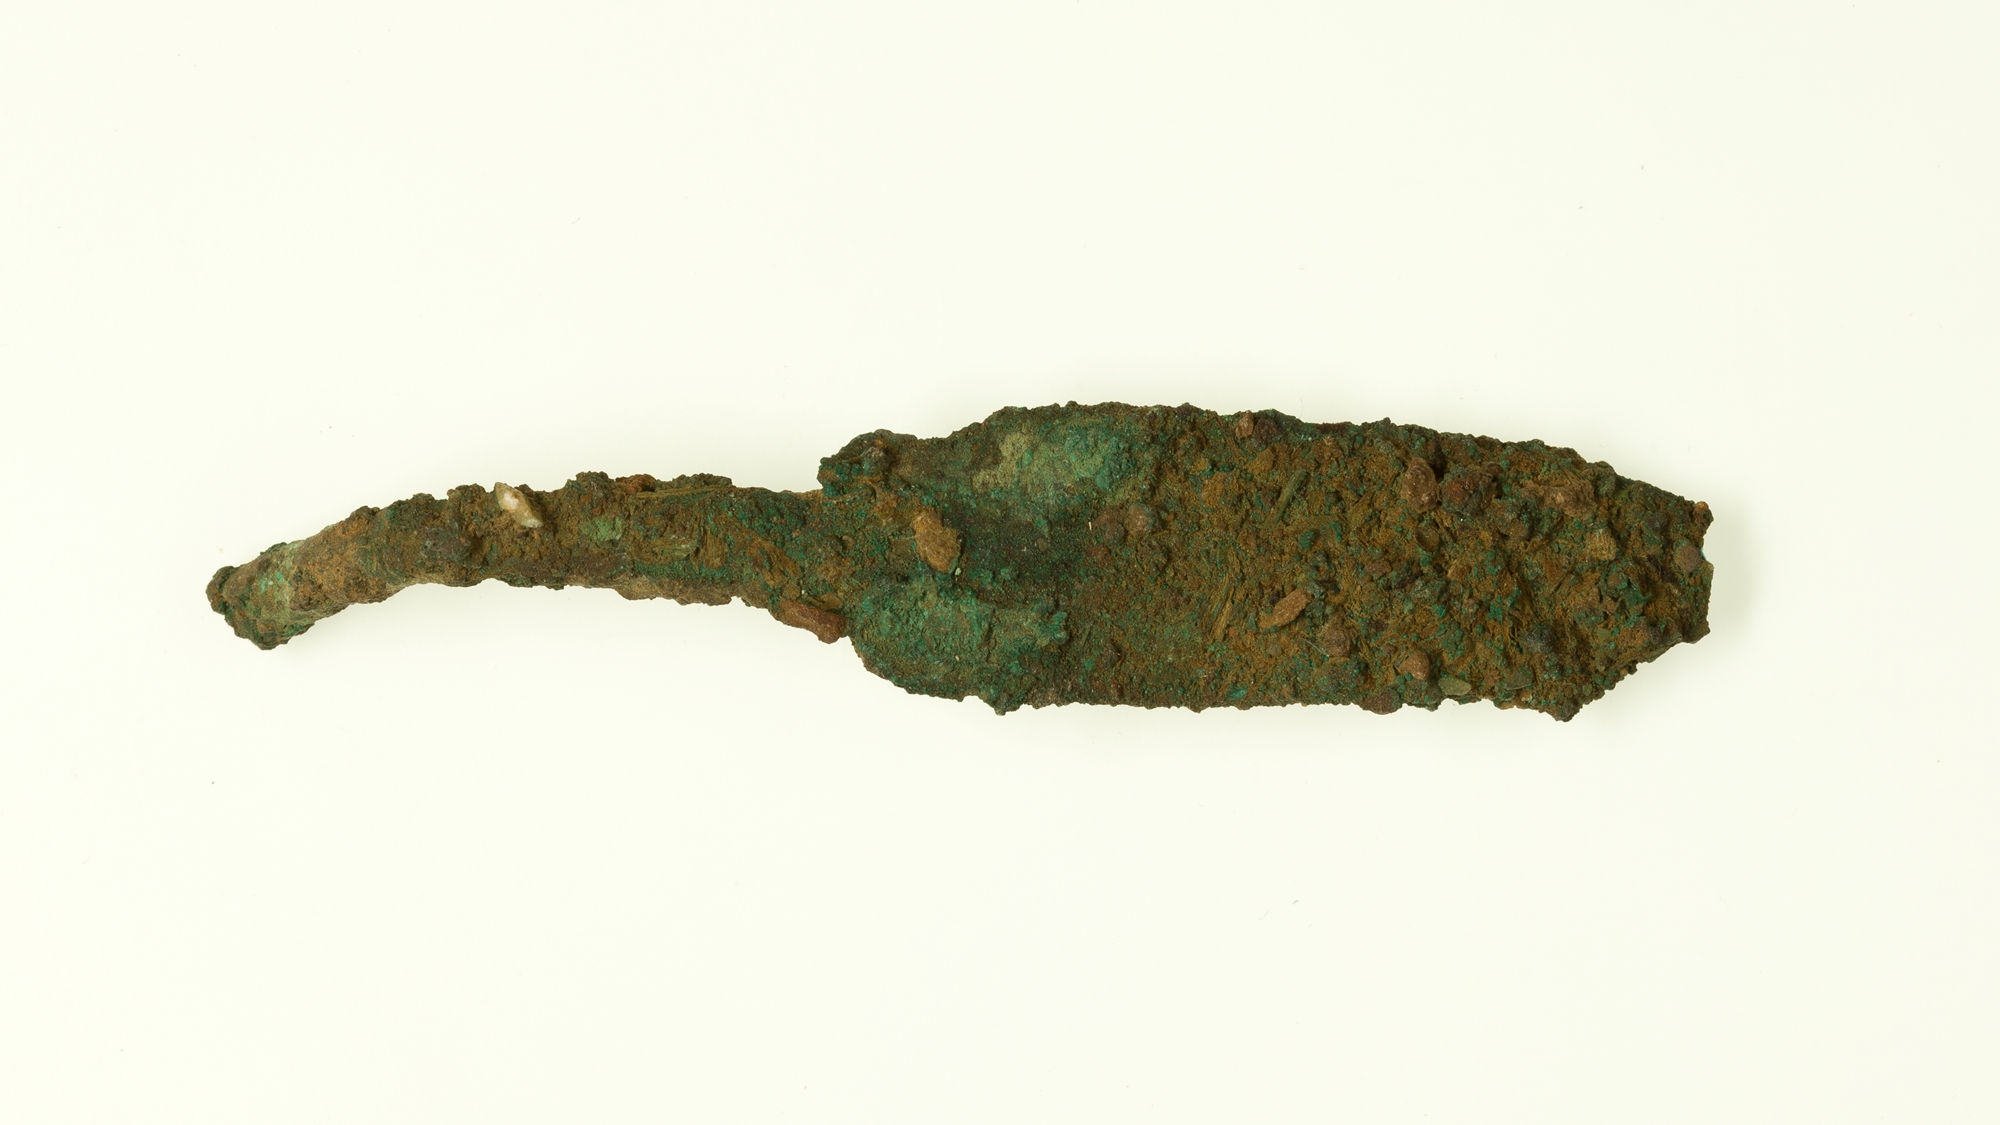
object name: cosmetic tool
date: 1295-1070 BCE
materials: bronze, copper alloy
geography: egypt